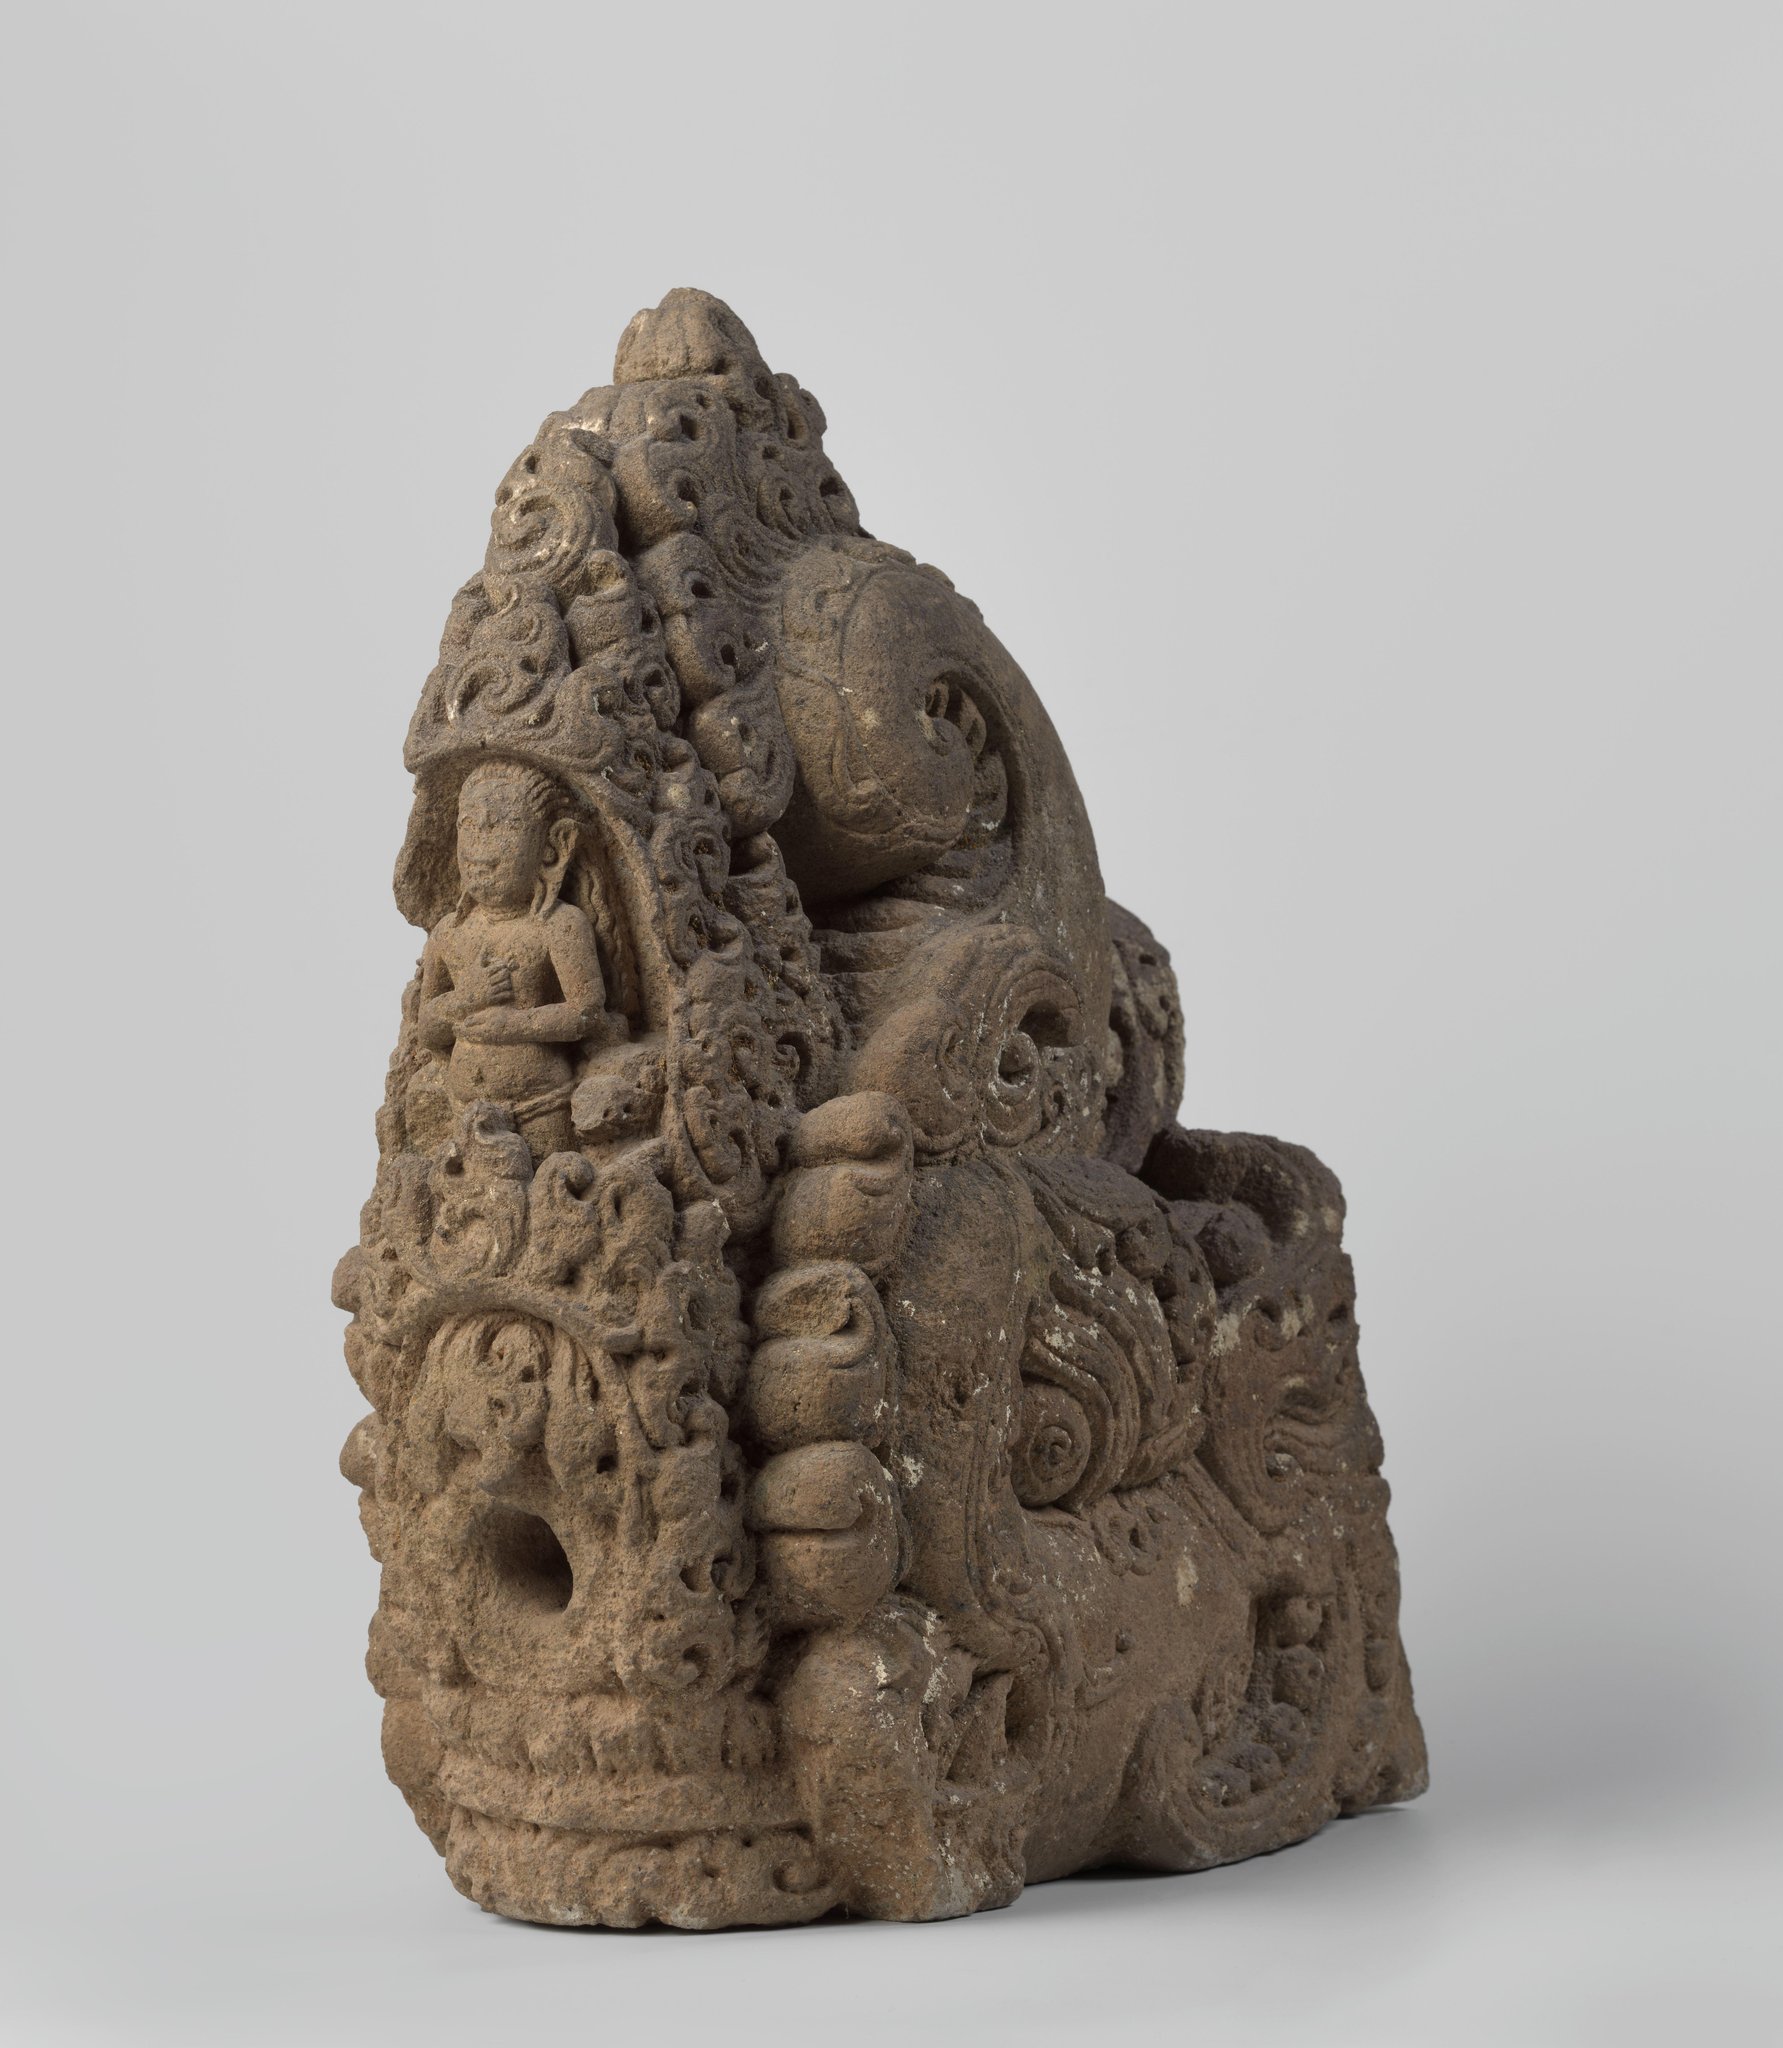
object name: sculpture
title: Makara waterspuwer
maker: Anonymous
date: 1000-1199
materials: rock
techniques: carved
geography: east java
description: De waterspuwer is gemaakt in de vorm van een makara - een mythisch waterwezen. Het water gaat bij de waterspuwer naar binnen door en goot in de achterkant en loopt naar buiten door de mond van de makara. Daarboven is een staande asceet uitgebeeld met lange haren en zijn handen in meditatiehouding.